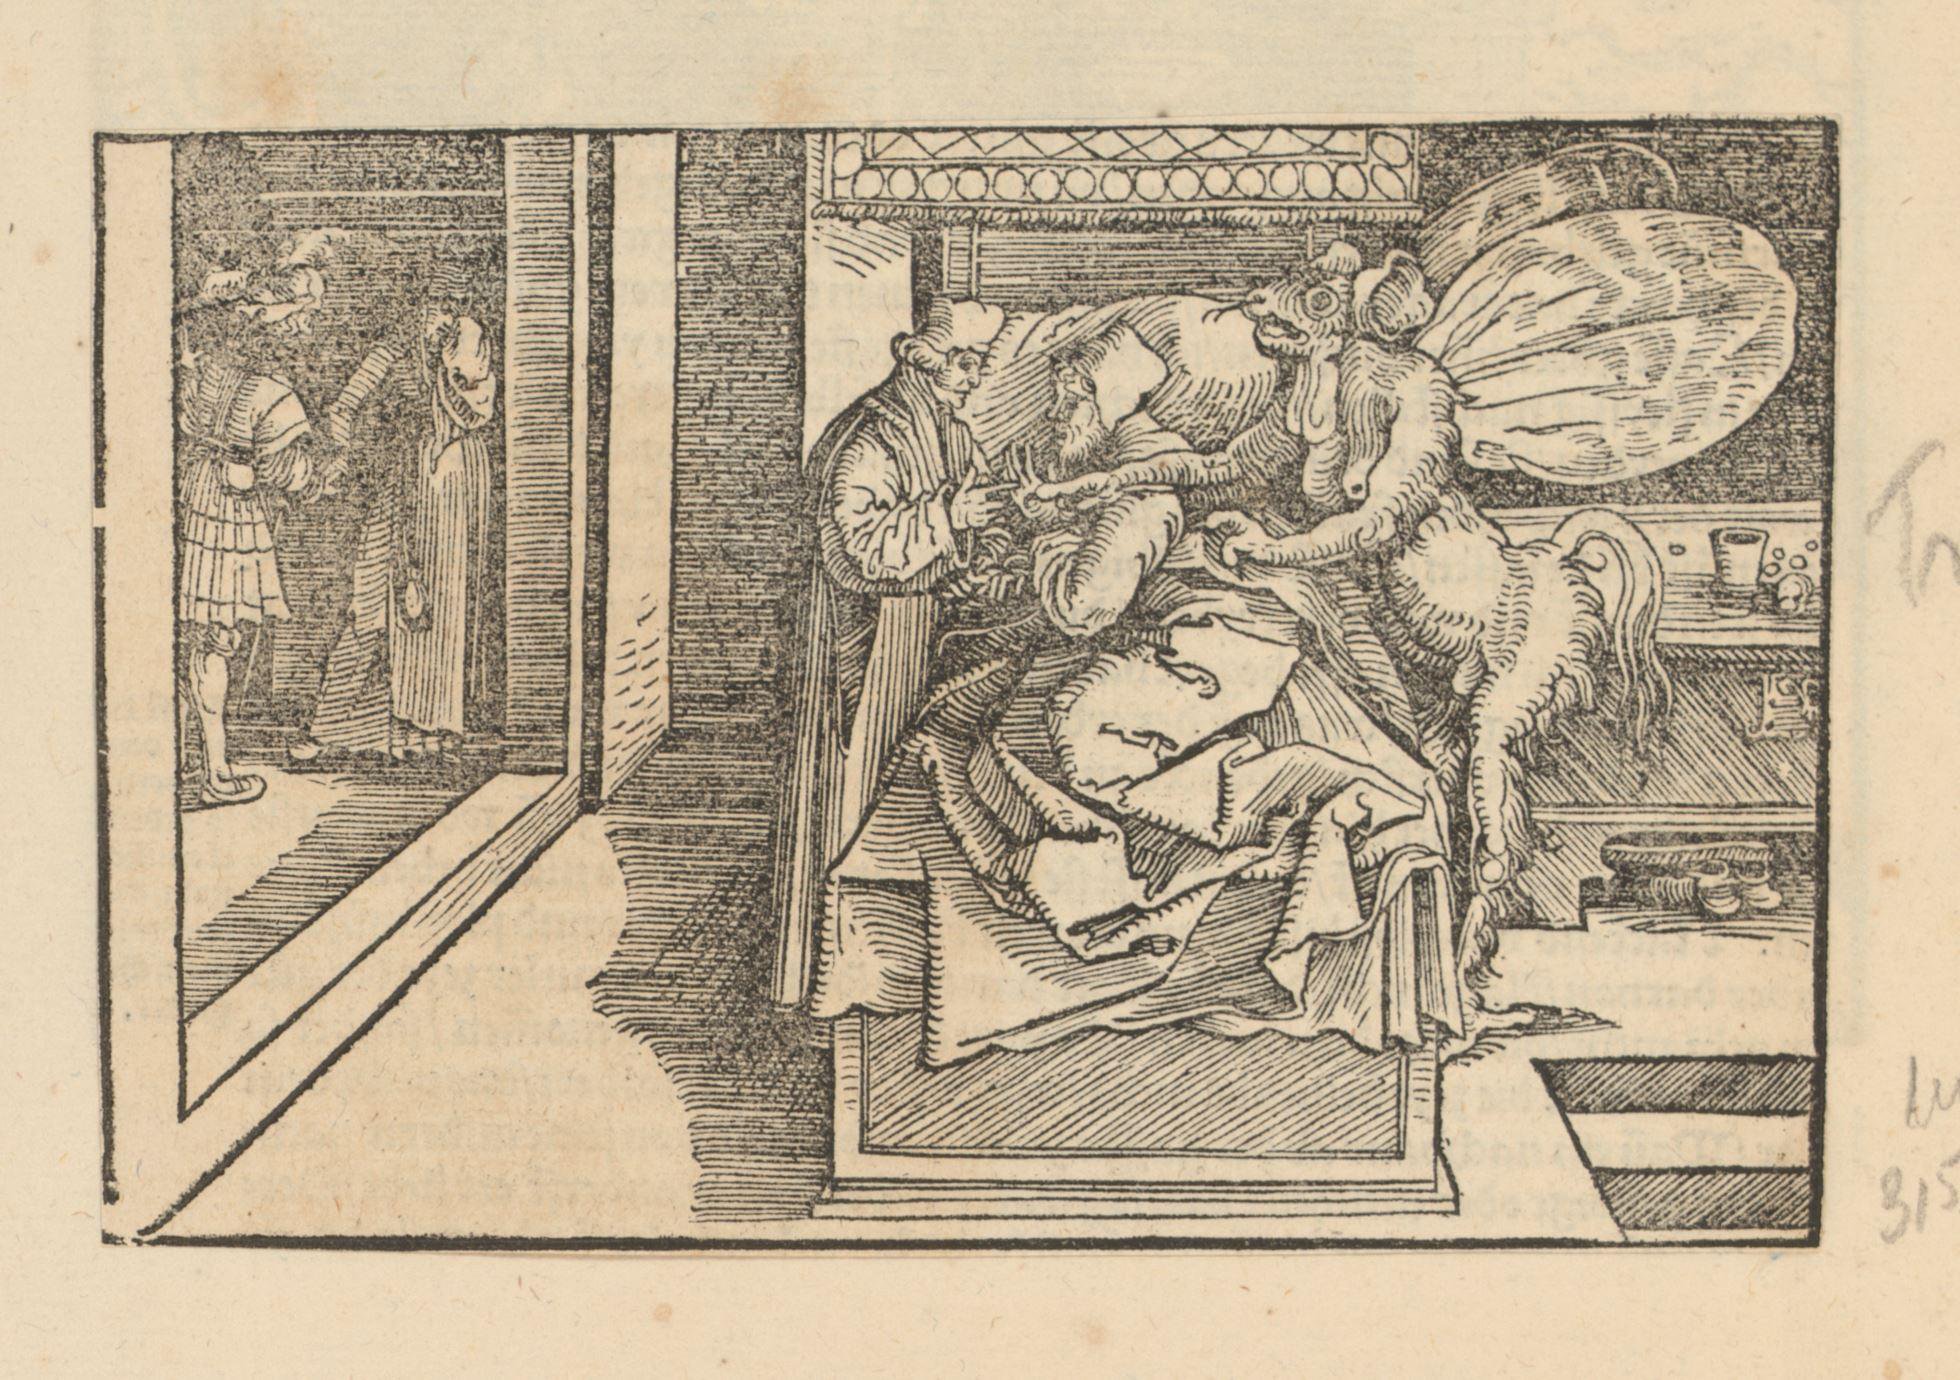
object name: print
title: Demon naast een sterfbed van een geestelijke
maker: Anonymous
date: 1514-1532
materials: paper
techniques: letterpress printing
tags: mistress, death struggle, inquiet death; fear of death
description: Deze prent is gebruikt in: Petrarca, Francesco. Von der Artzney bayder Glück, des guten und widerwertigen: unnd weß sich ain yeder inn Gelück und Unglück halten sol (...). Augsburg: Heinrich Steiner, 1532. Deze uitgave is ook bekend onder de titel 'Trostspiegel in Glück und Unglück'.